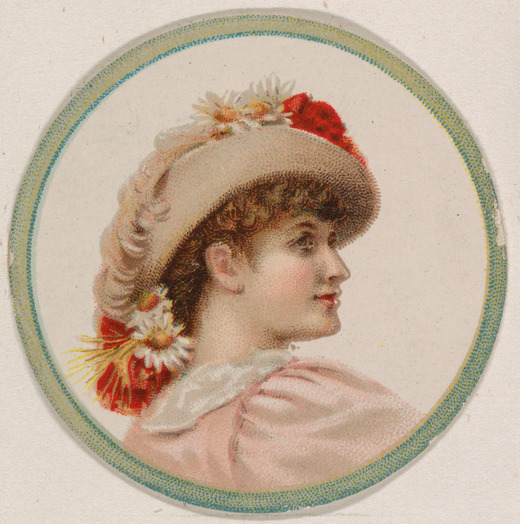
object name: print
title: Woman wearing hat with flowers and feathers, from the Novelties series (N228, Type 2) issued by Kinney Bros.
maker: kinney brothers tobacco company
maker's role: publisher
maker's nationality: american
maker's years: 1869-2011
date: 1889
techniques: color lithograph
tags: profiles,women